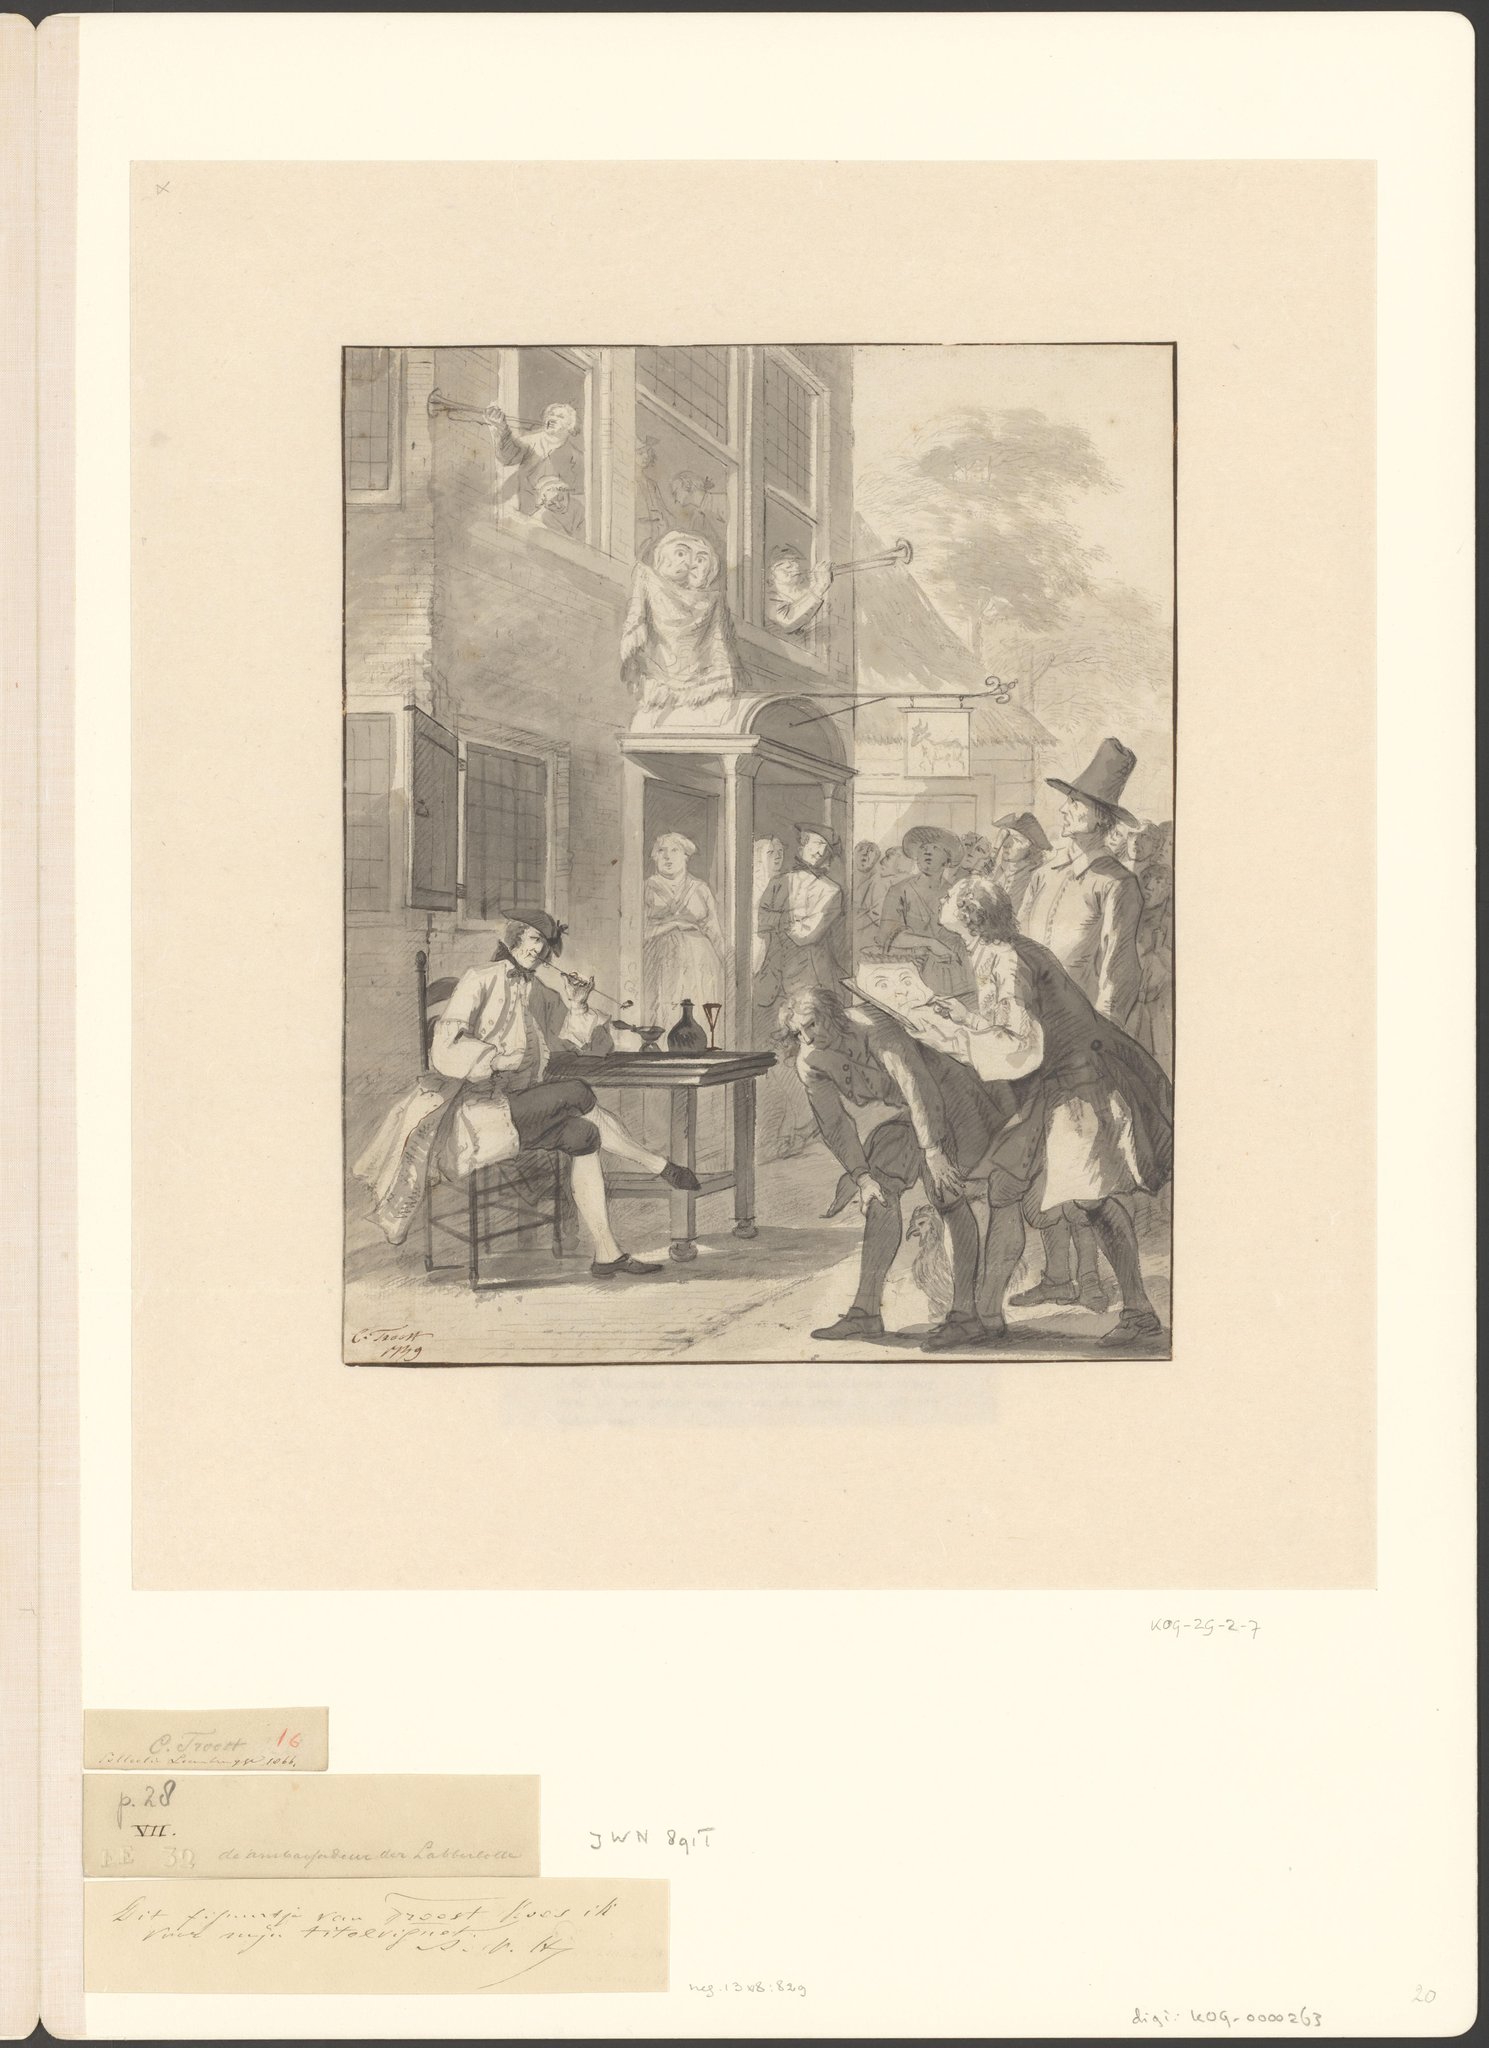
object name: drawing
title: Ambassadeur der Laberlotten vertoont zich voor het venster van de herberg 't Bokki in de Haarlemmerhout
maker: cornelis troost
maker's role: draughtsman, painter, print maker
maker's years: 1696-1750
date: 1739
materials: chalk, ink, paper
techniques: brush, pen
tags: drawing, sketch, ambassador, disguise, hotel, hostelry, inn, artist at work, in his workshop - bb - out of doors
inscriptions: collector's mark: Lugt 2488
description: 'De misleyden': de ambassadeur der Labberlotten vertoont zich voor het venster van de herberg 't Bokki ('t Bokje) in de Haarlemmerhout (een grap bedreven door Jacob Campo Weyerman en consorten in 1739). Een groep mensen kijkt naar het als een gezicht beschilderde achterwerk, uit het venster van de herberg gestoken.